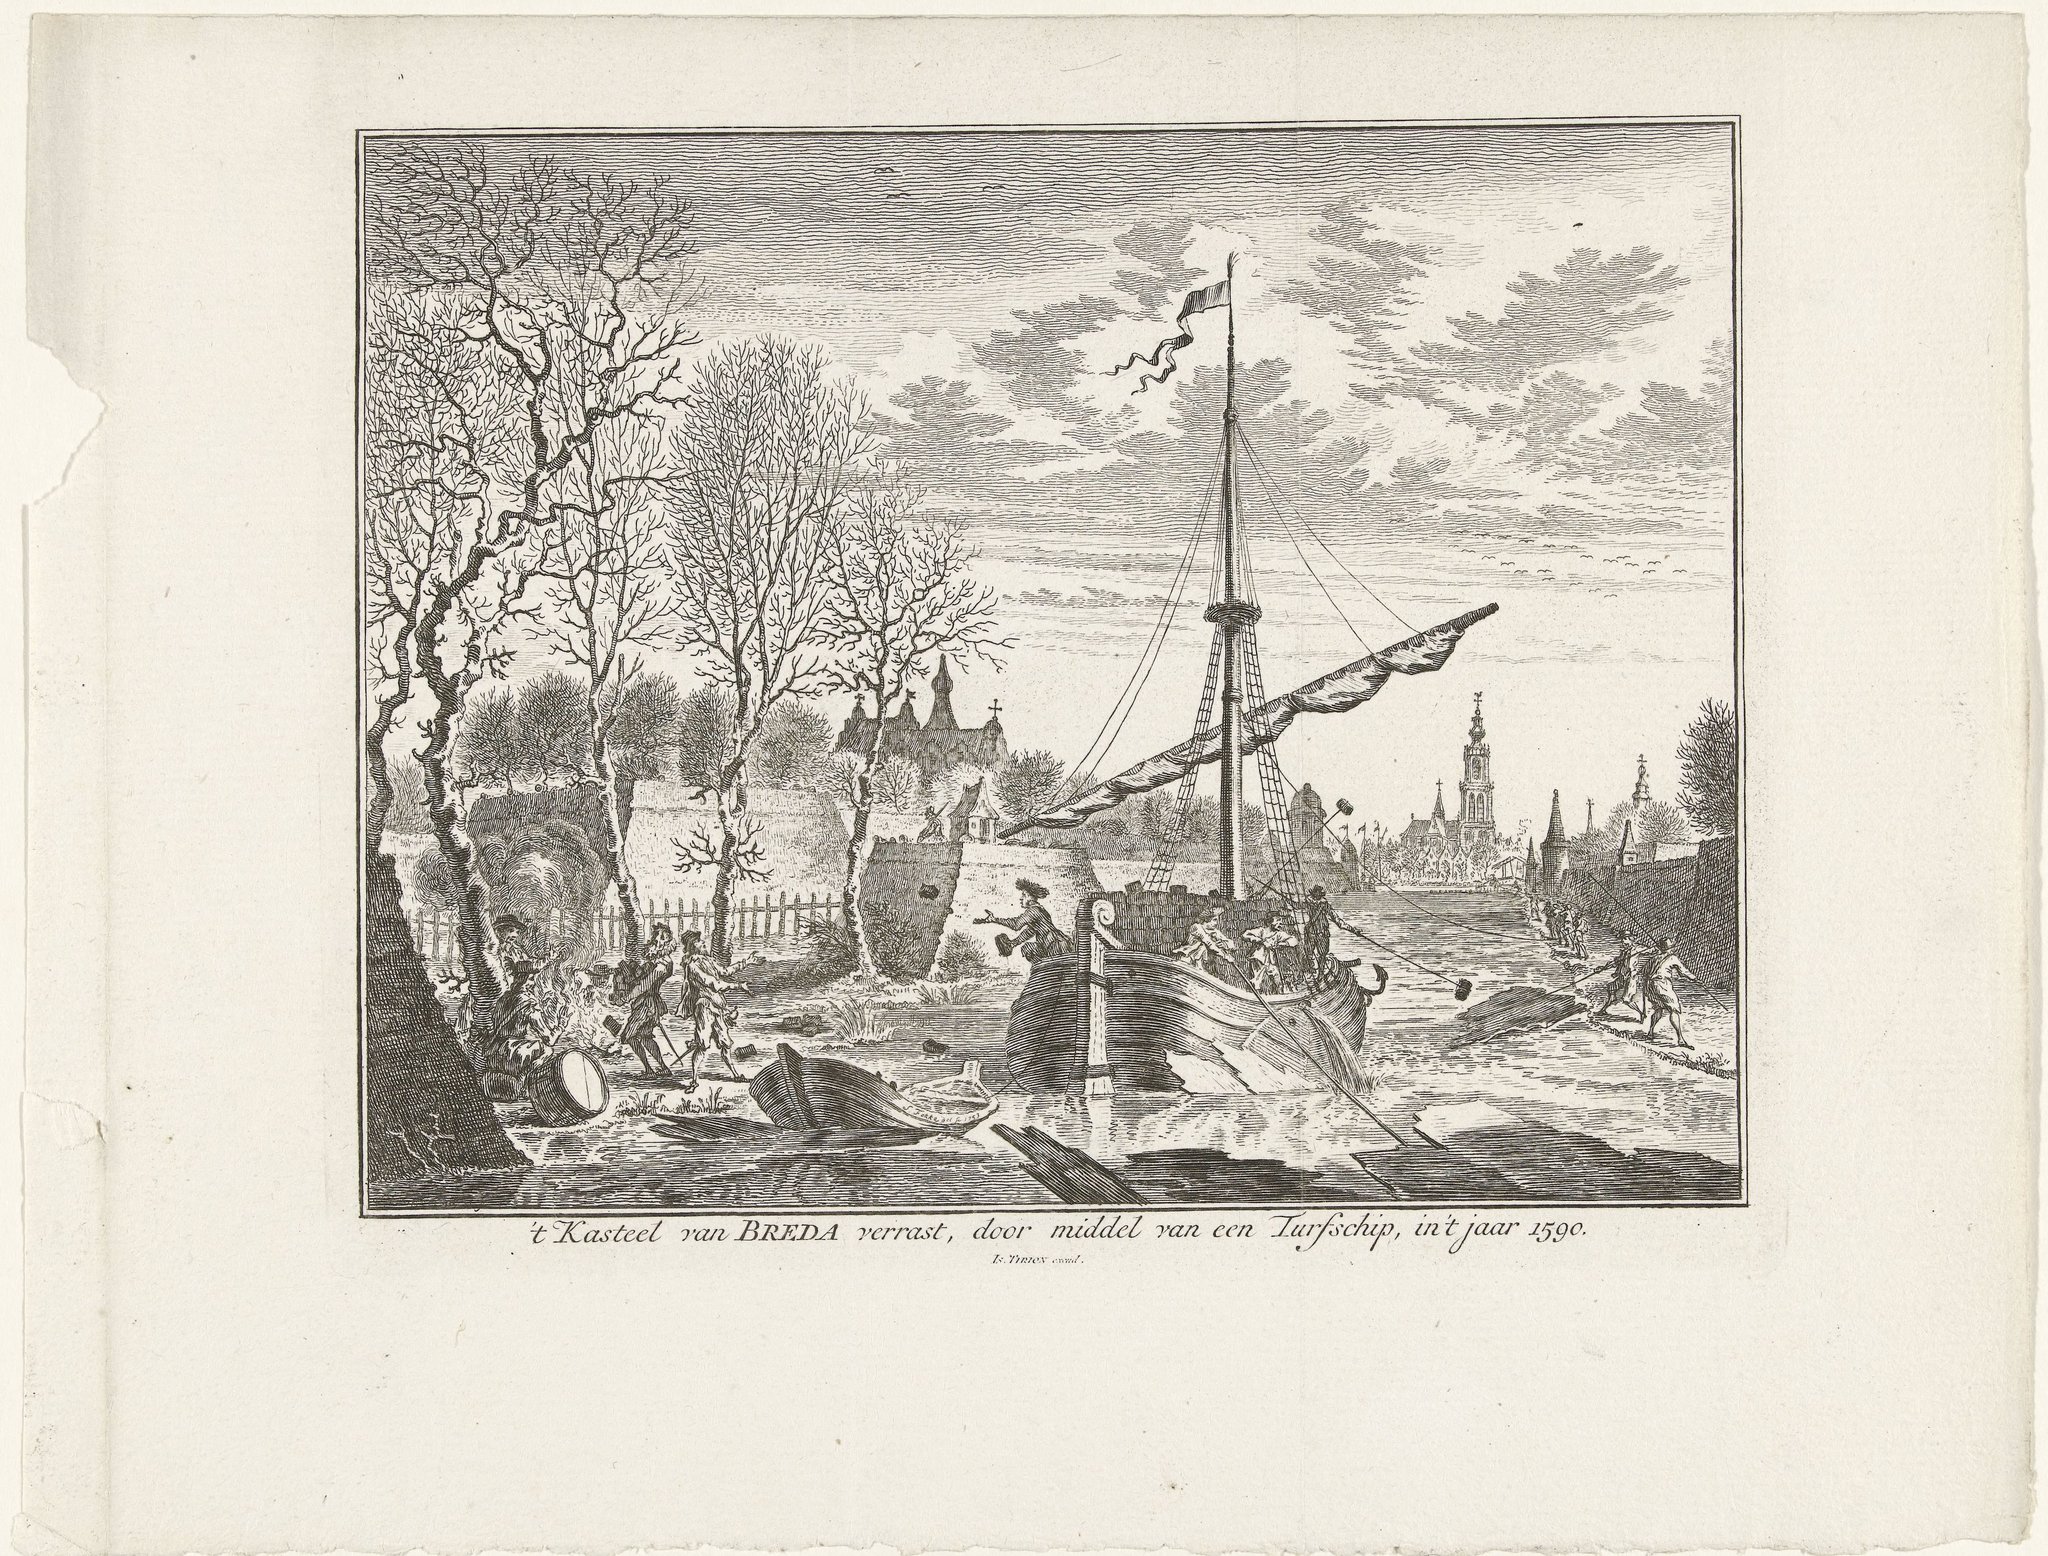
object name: print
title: 't Kasteel van Breda verrast, door middel van een Turfschip, in 't jaar 1590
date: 1752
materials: paper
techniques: etching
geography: amsterdam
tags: capture of city (after the siege)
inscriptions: collector's mark: Lugt 2228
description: Inname van Breda door middel van het turfschip. Het schip ligt op het ijs voor het kasteel.